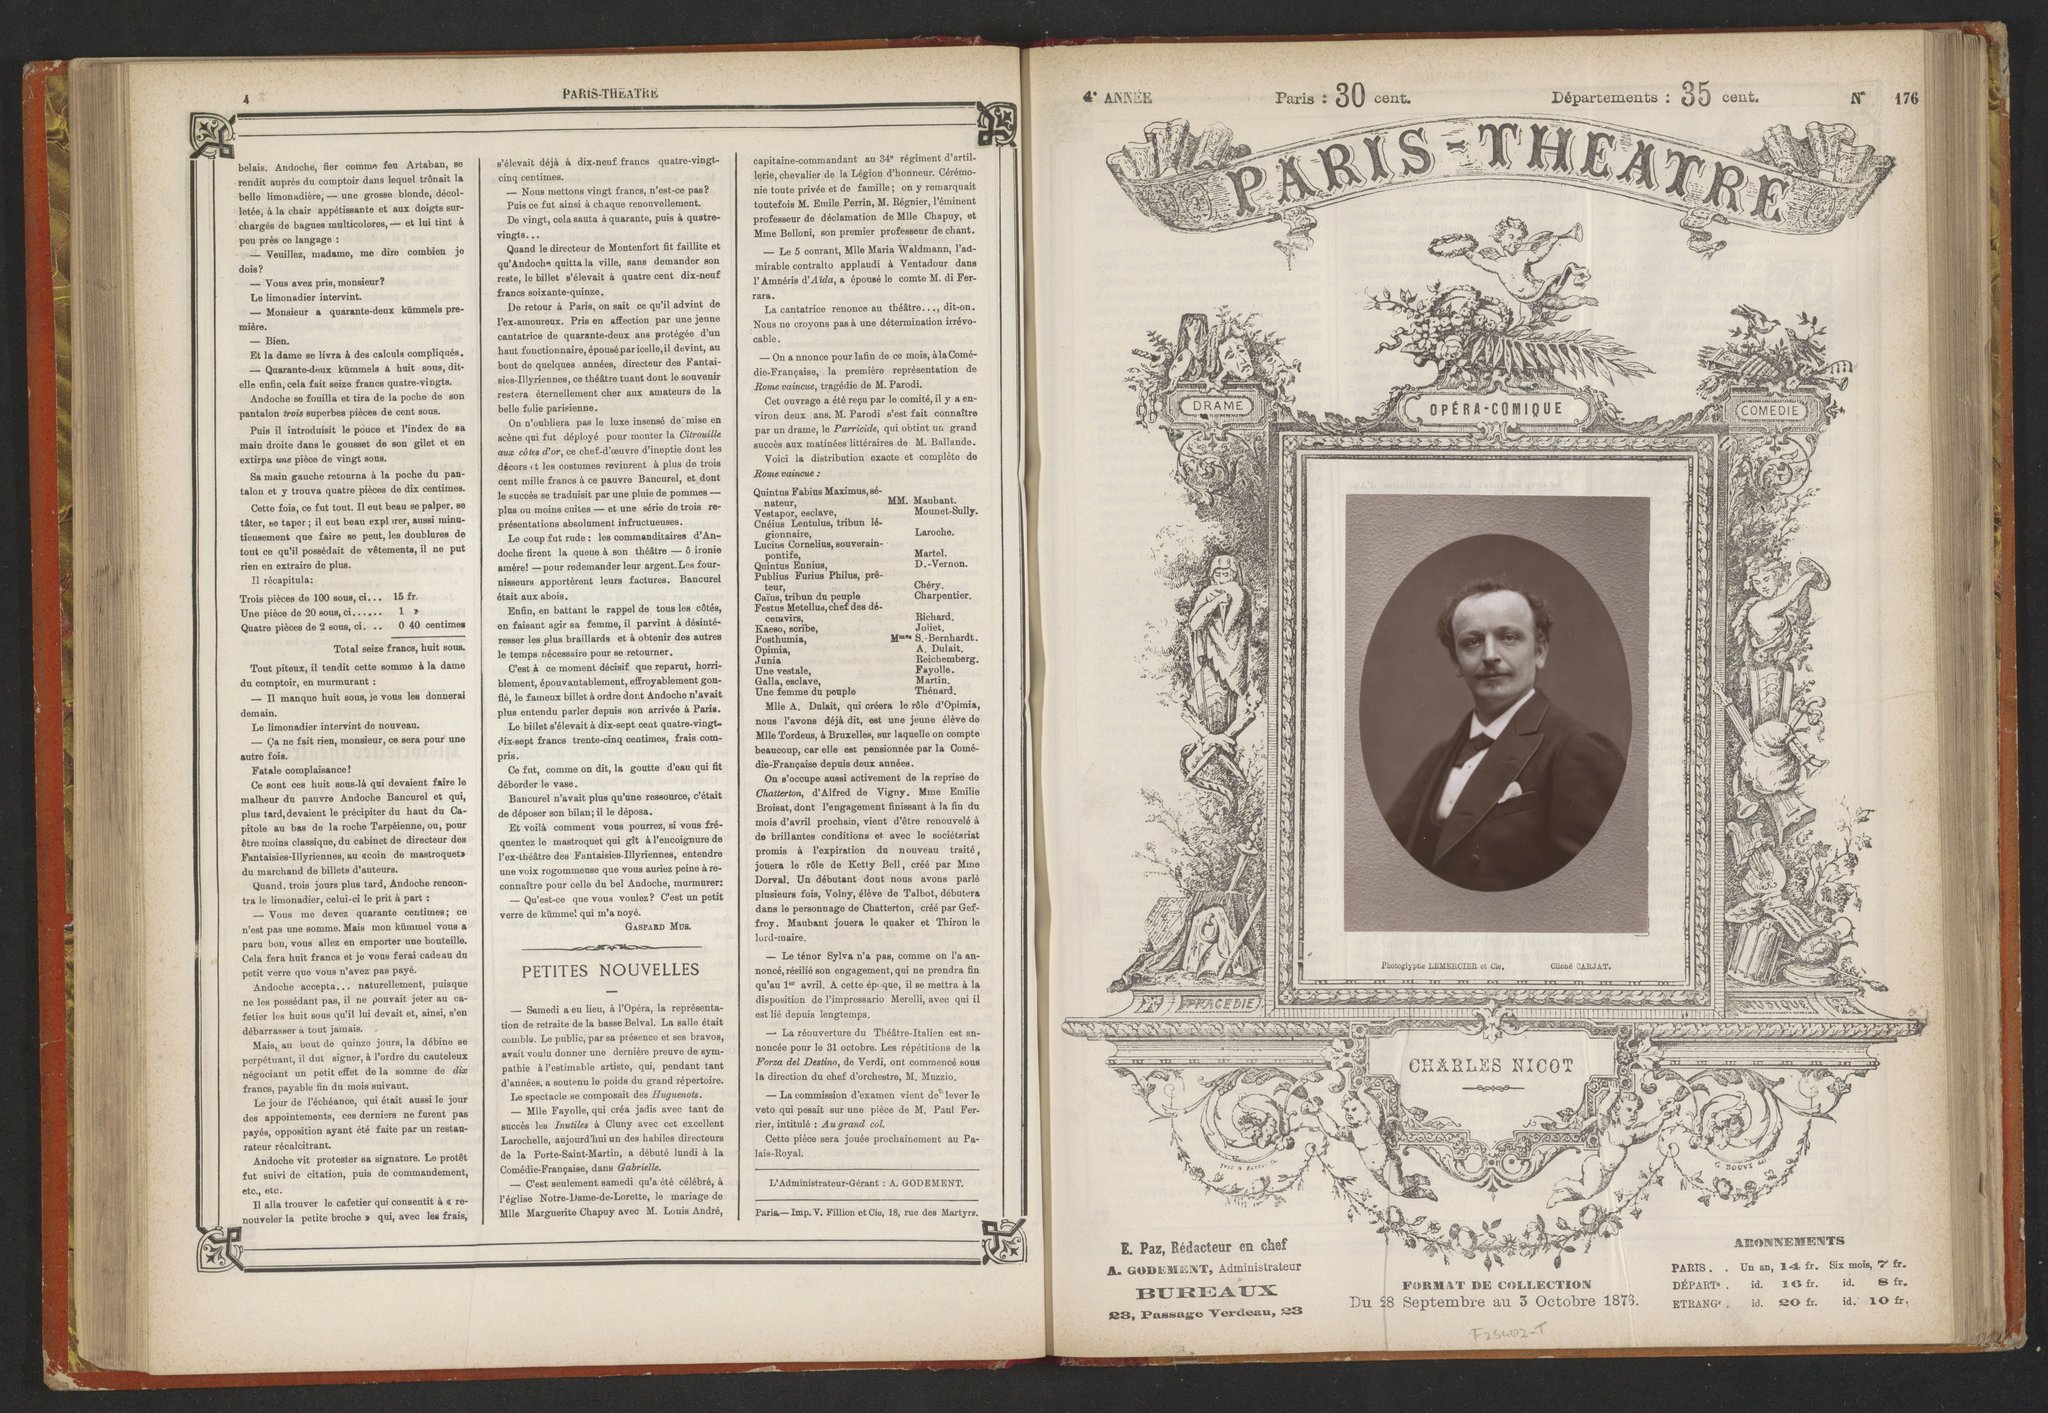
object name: page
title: Charles Nicot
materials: paper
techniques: woodburytype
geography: france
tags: portrait of opera-singer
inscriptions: number: ‘No 176’, inscription: ‘Du 28 Septembre au 3 Octobre 1876’